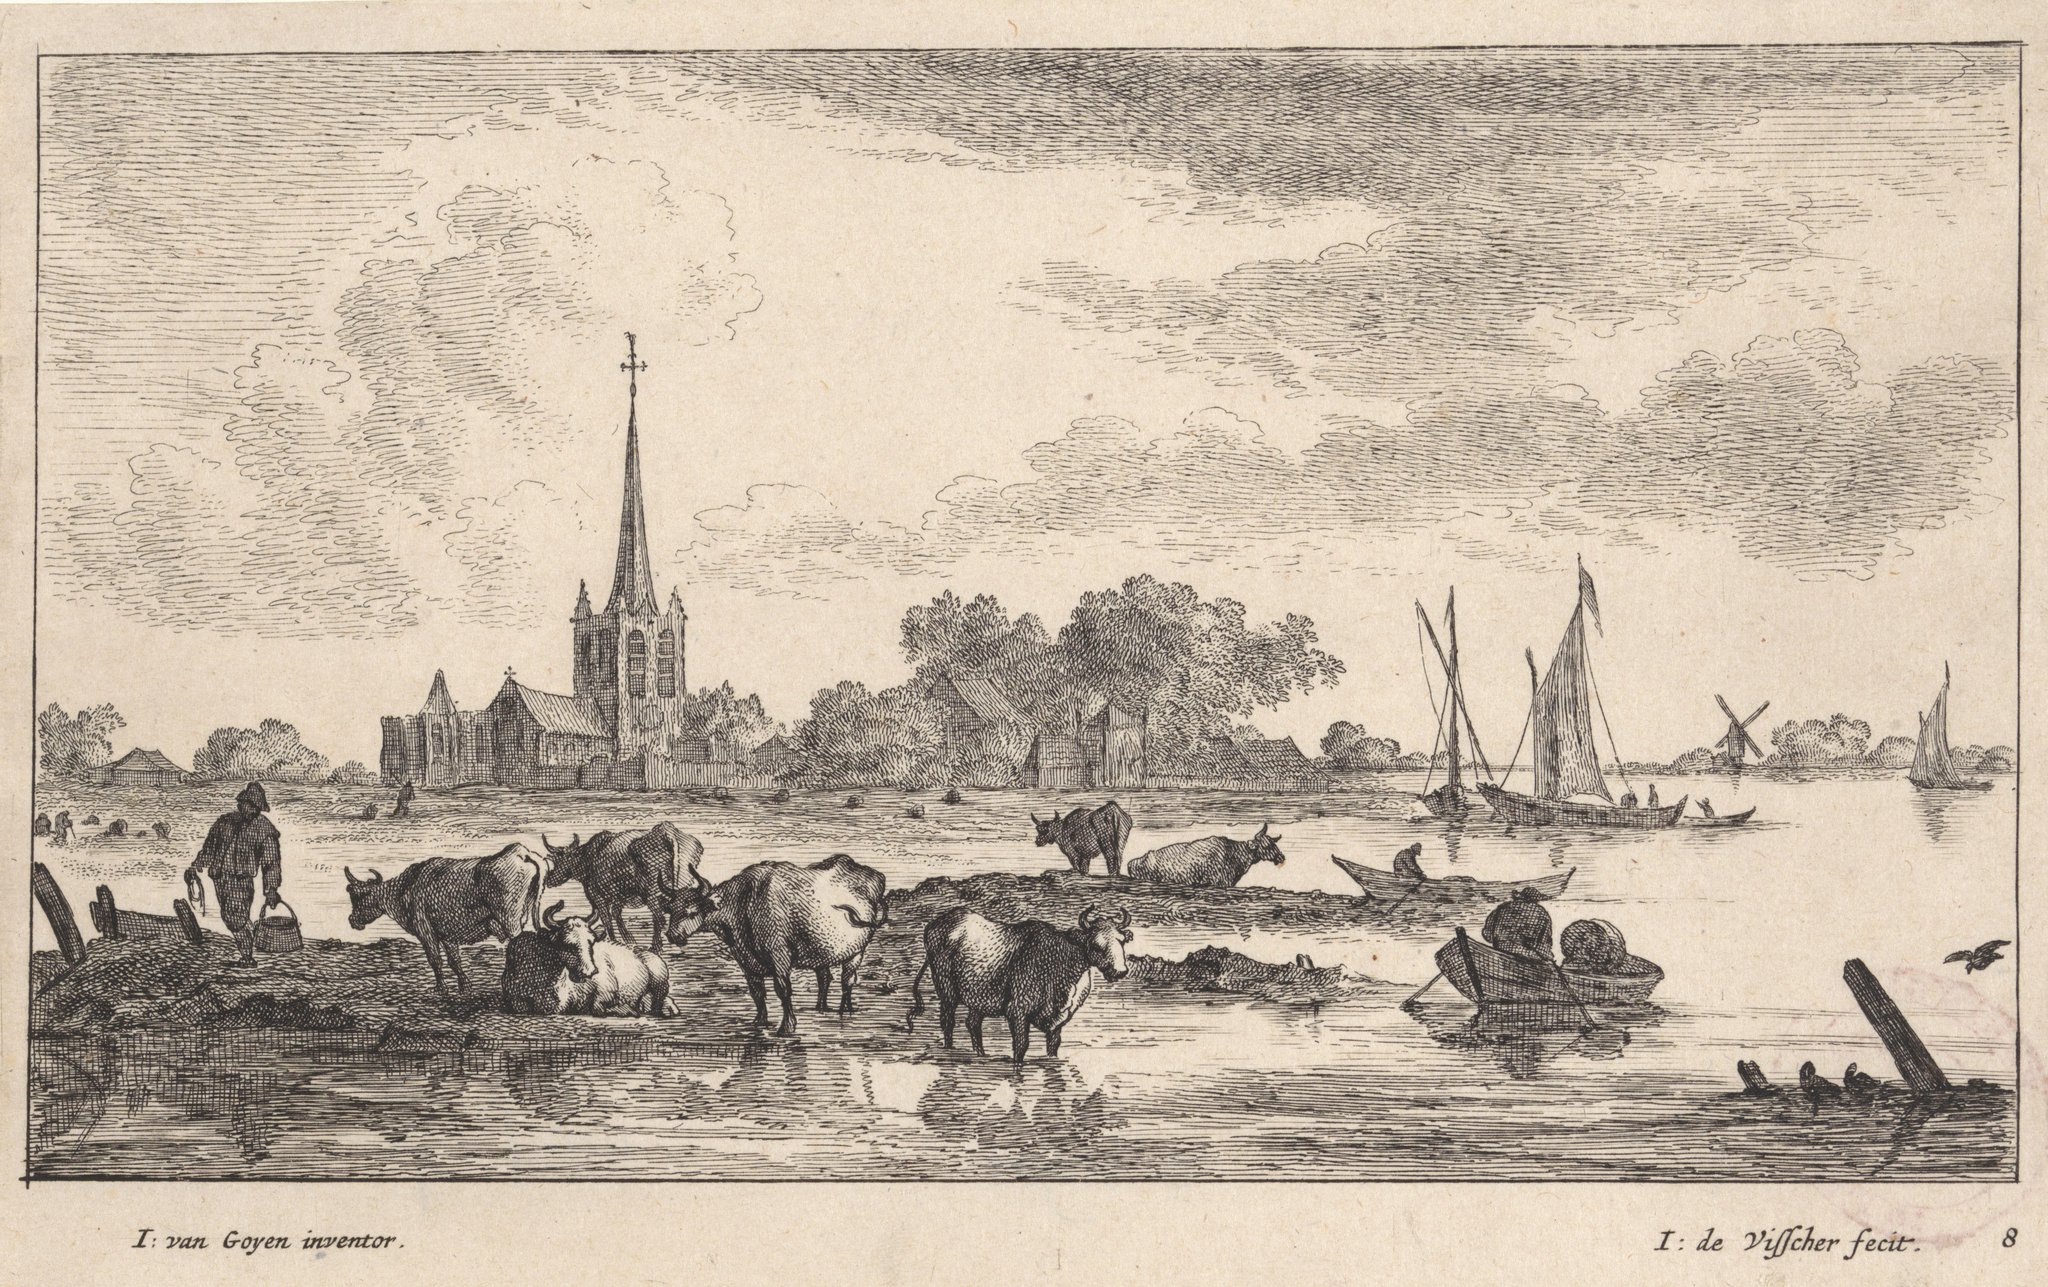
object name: print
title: Grazende koeien in de uiterwaarden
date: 1682-1709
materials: paper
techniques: engraving, etching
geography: northern netherlands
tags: cow, sailing-ship, sailing-boat, river, church (exterior), windmill in landscape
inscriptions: collector's mark: Lugt 240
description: In de uiterwaarden doet een kudde koeien zich tegoed aan gras en water. Een boer met in zijn hand een emmer, loopt juist van de kudde vandaan. Op de rivier zeilschepen en roeiboten. Aan de overzijde van het water een dorp met een kerk en rechts een molen.